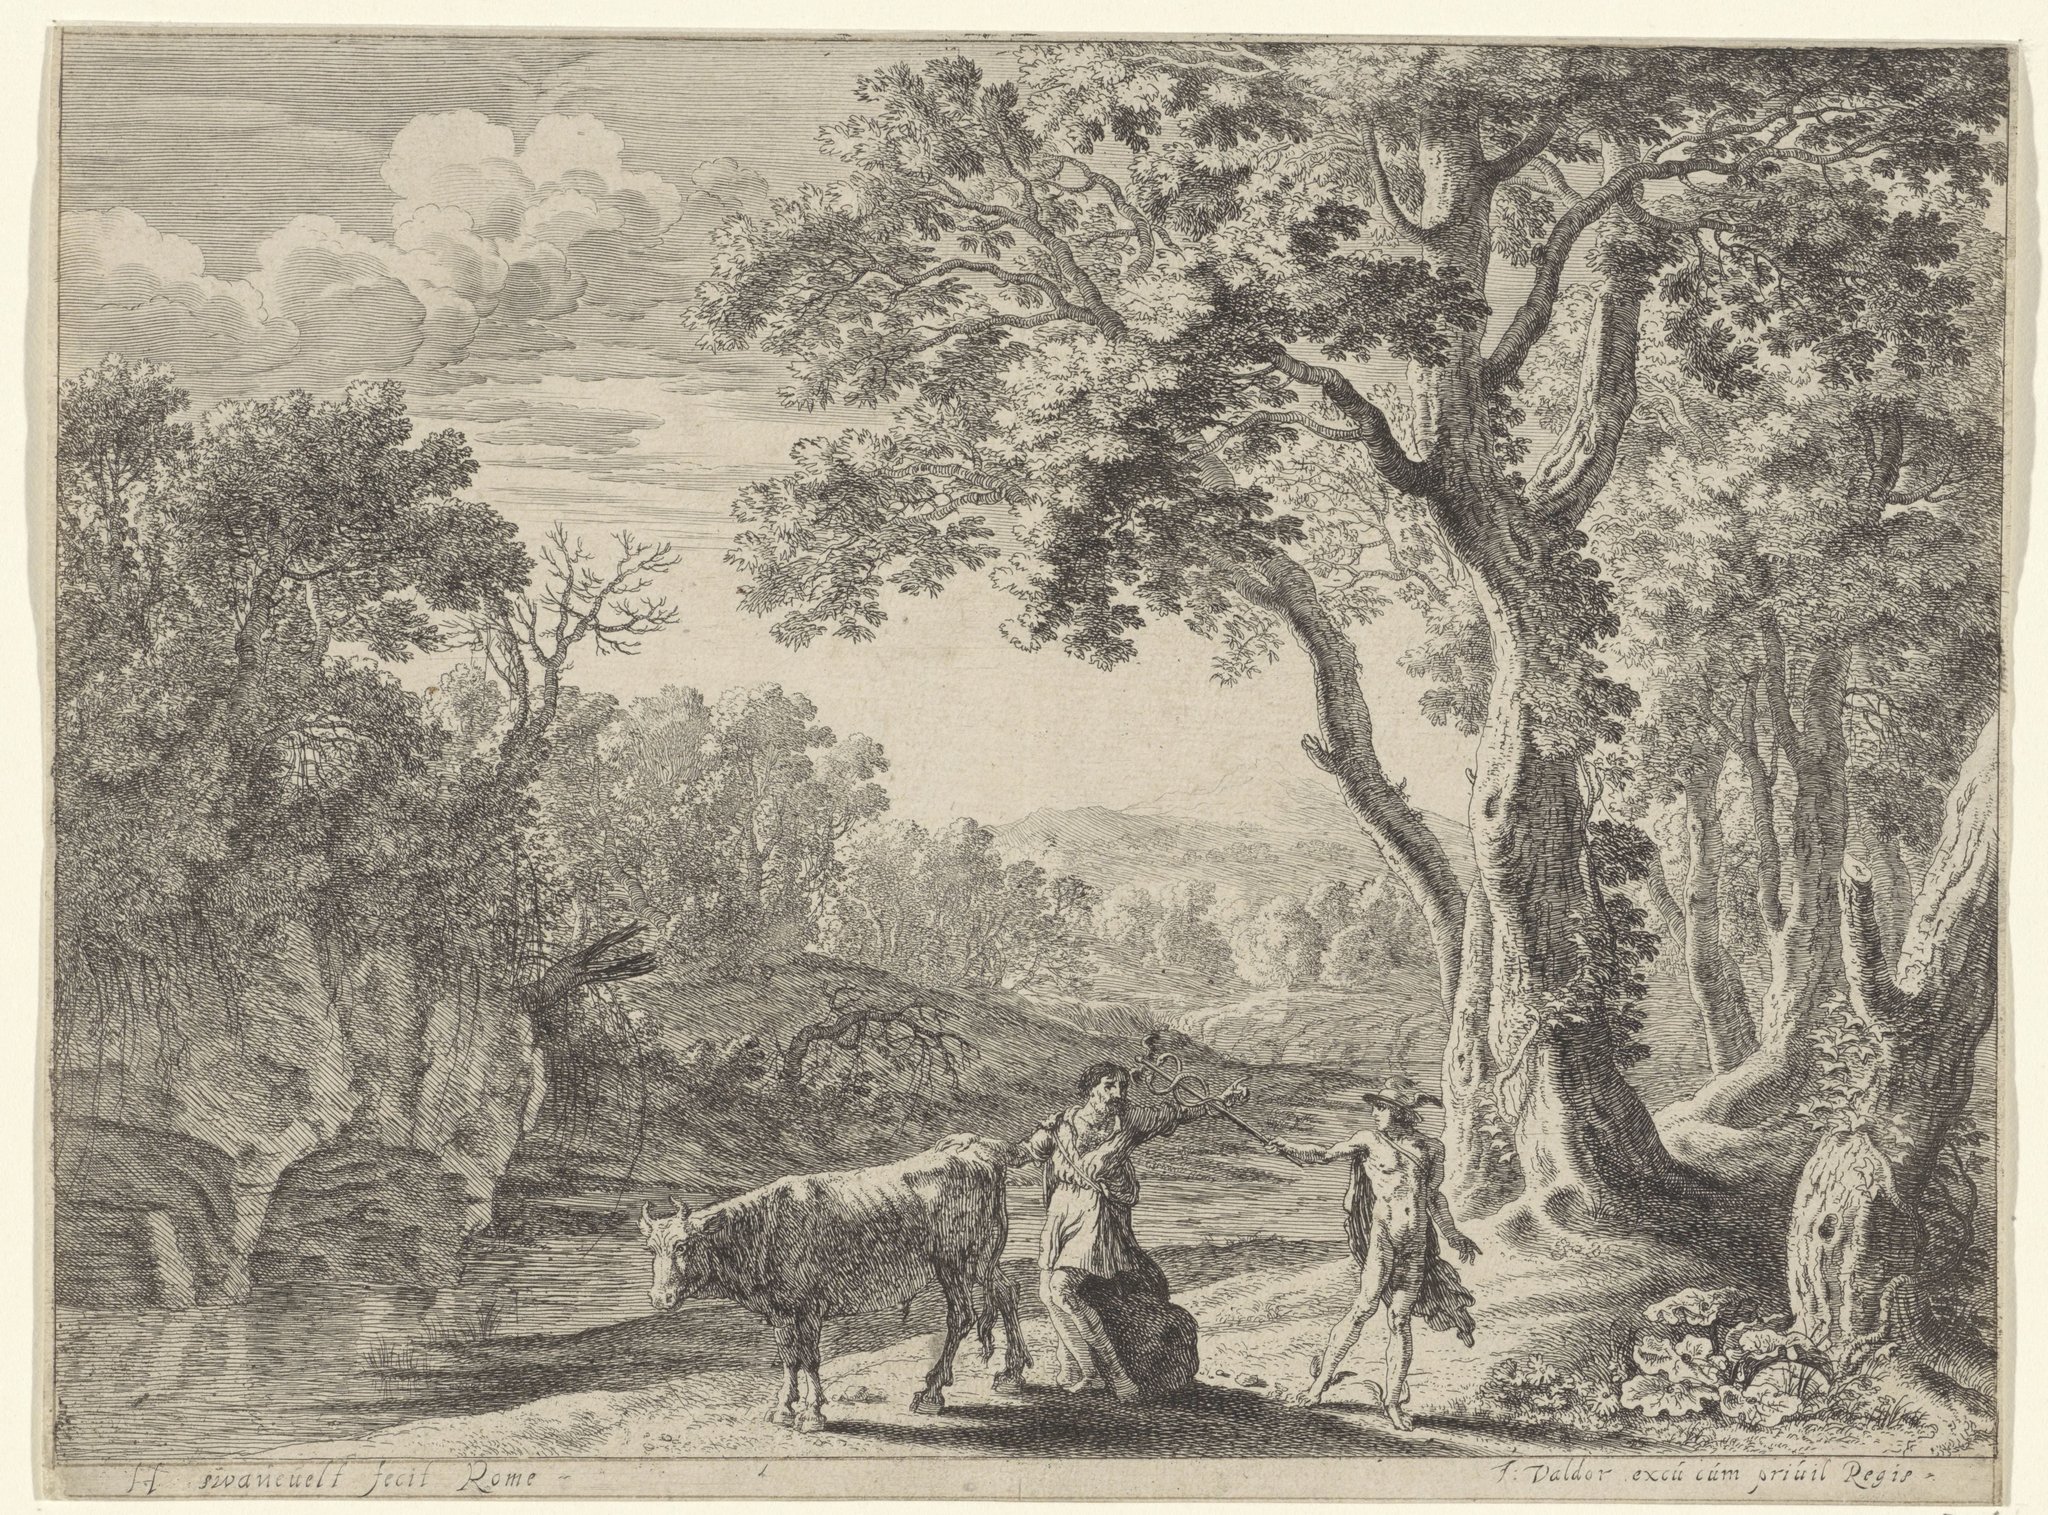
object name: print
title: Mercurius verandert Battus in steen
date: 1643-1671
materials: paper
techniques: etching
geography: rome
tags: battus changed into a touchstone: for violating the promise to keep mercury's theft of apollo's cattle a secret, mercury turns battus, the shepherd, into a touchstone (ovid, metamorphoses ii 705)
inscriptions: collector's mark: Lugt 240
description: In een bosrijk landschap met een waterpartij staat boer Battus achter zijn koe op de voorgrond. Met zijn opgeheven linkerhand wijst hij in de richting van Mercurius die naast hem staat. Mercurius draagt gevleugelde schoenen, zijn gevleugelde helm en zijn caduceus, waarmee hij Battus aanraakt om hem in steen te veranderen.